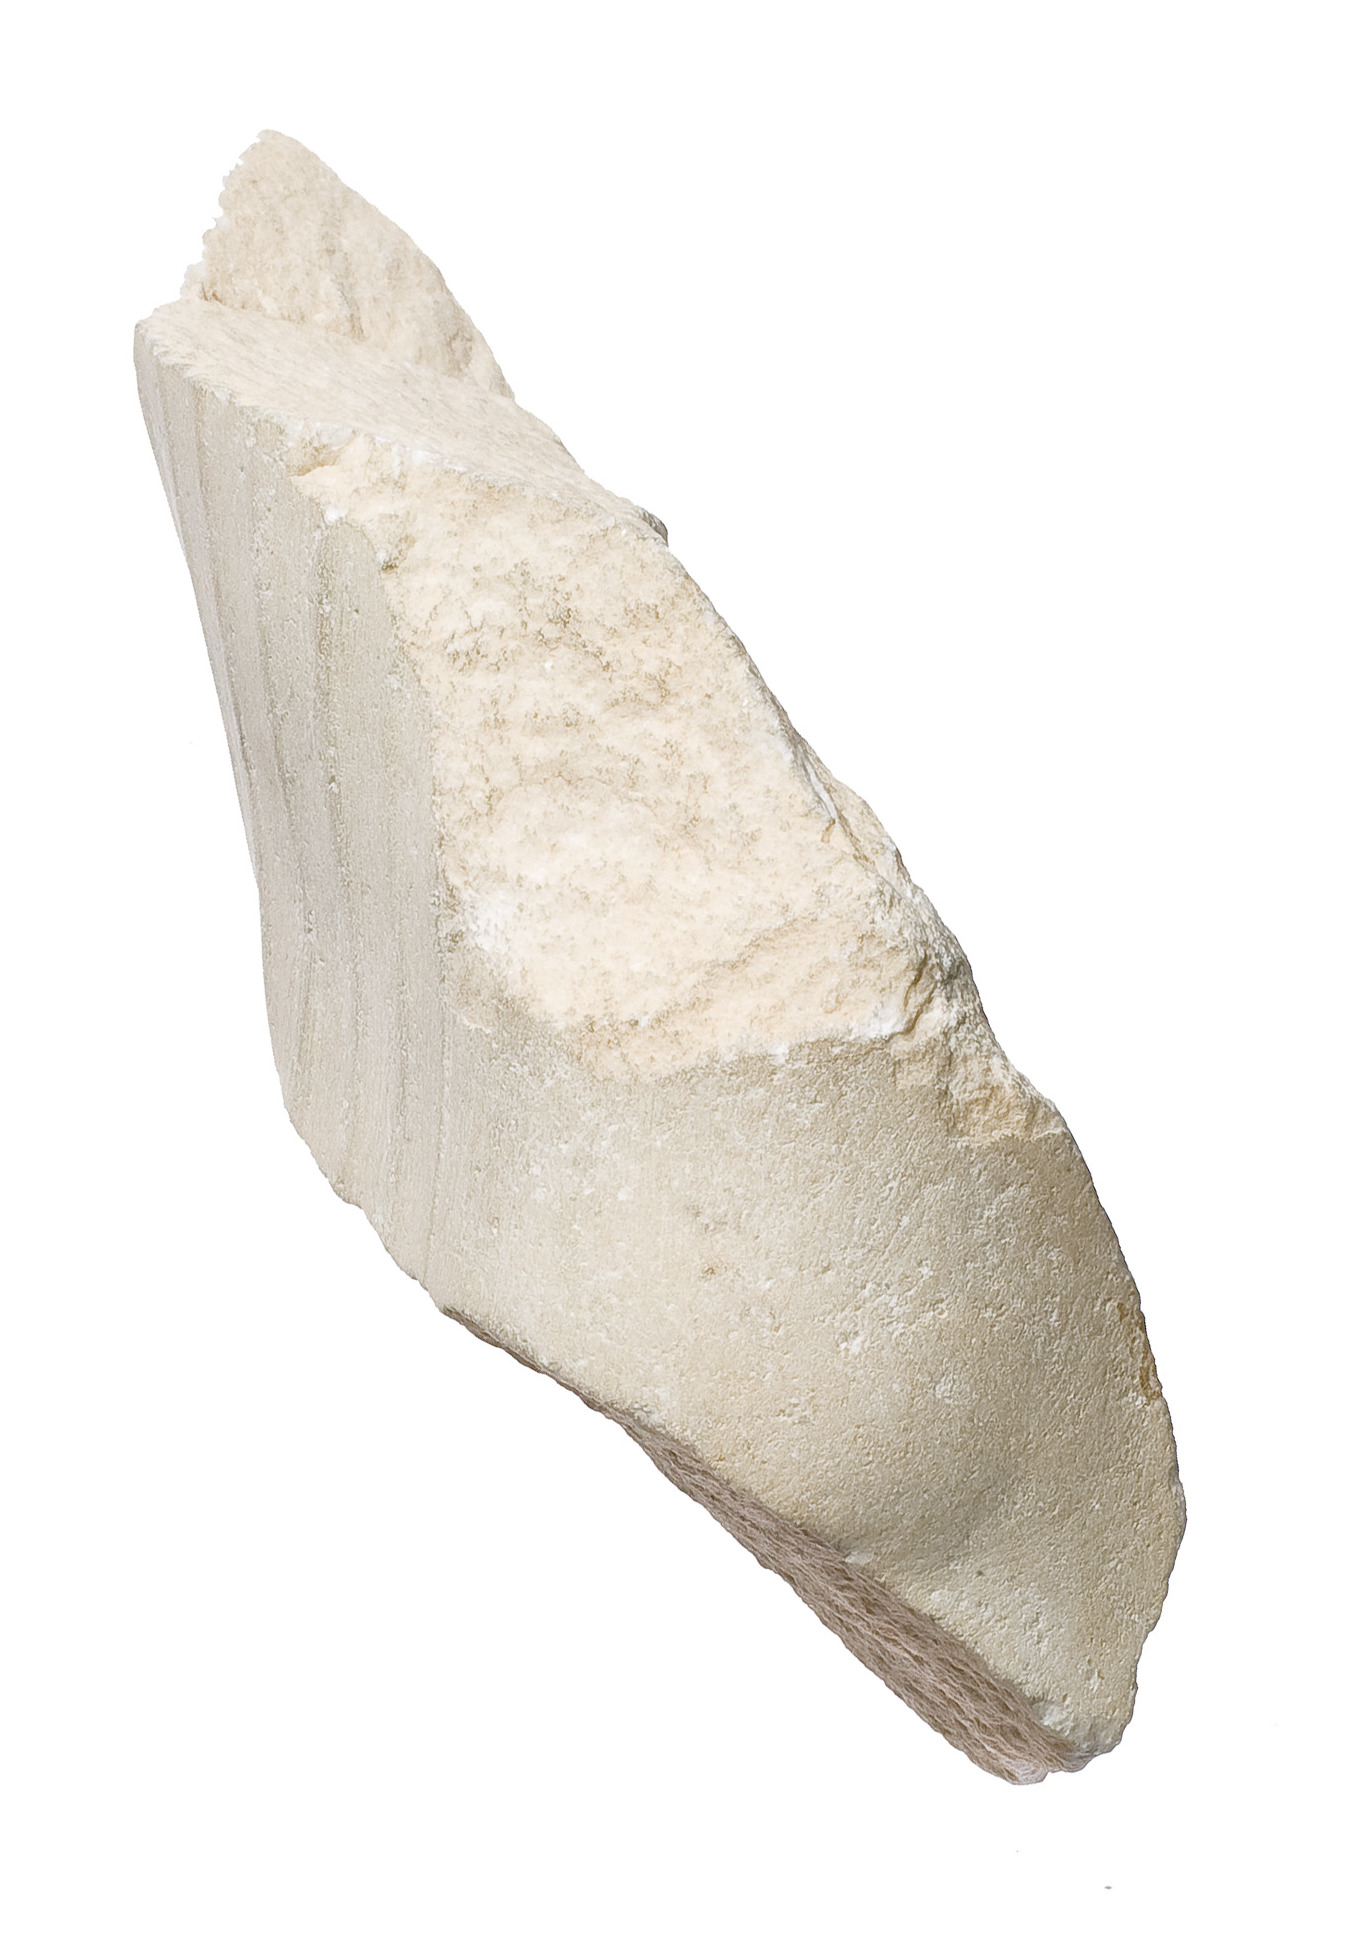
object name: knee with male garment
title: Knee with kilt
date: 1353-1336 BCE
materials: limestone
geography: egypt